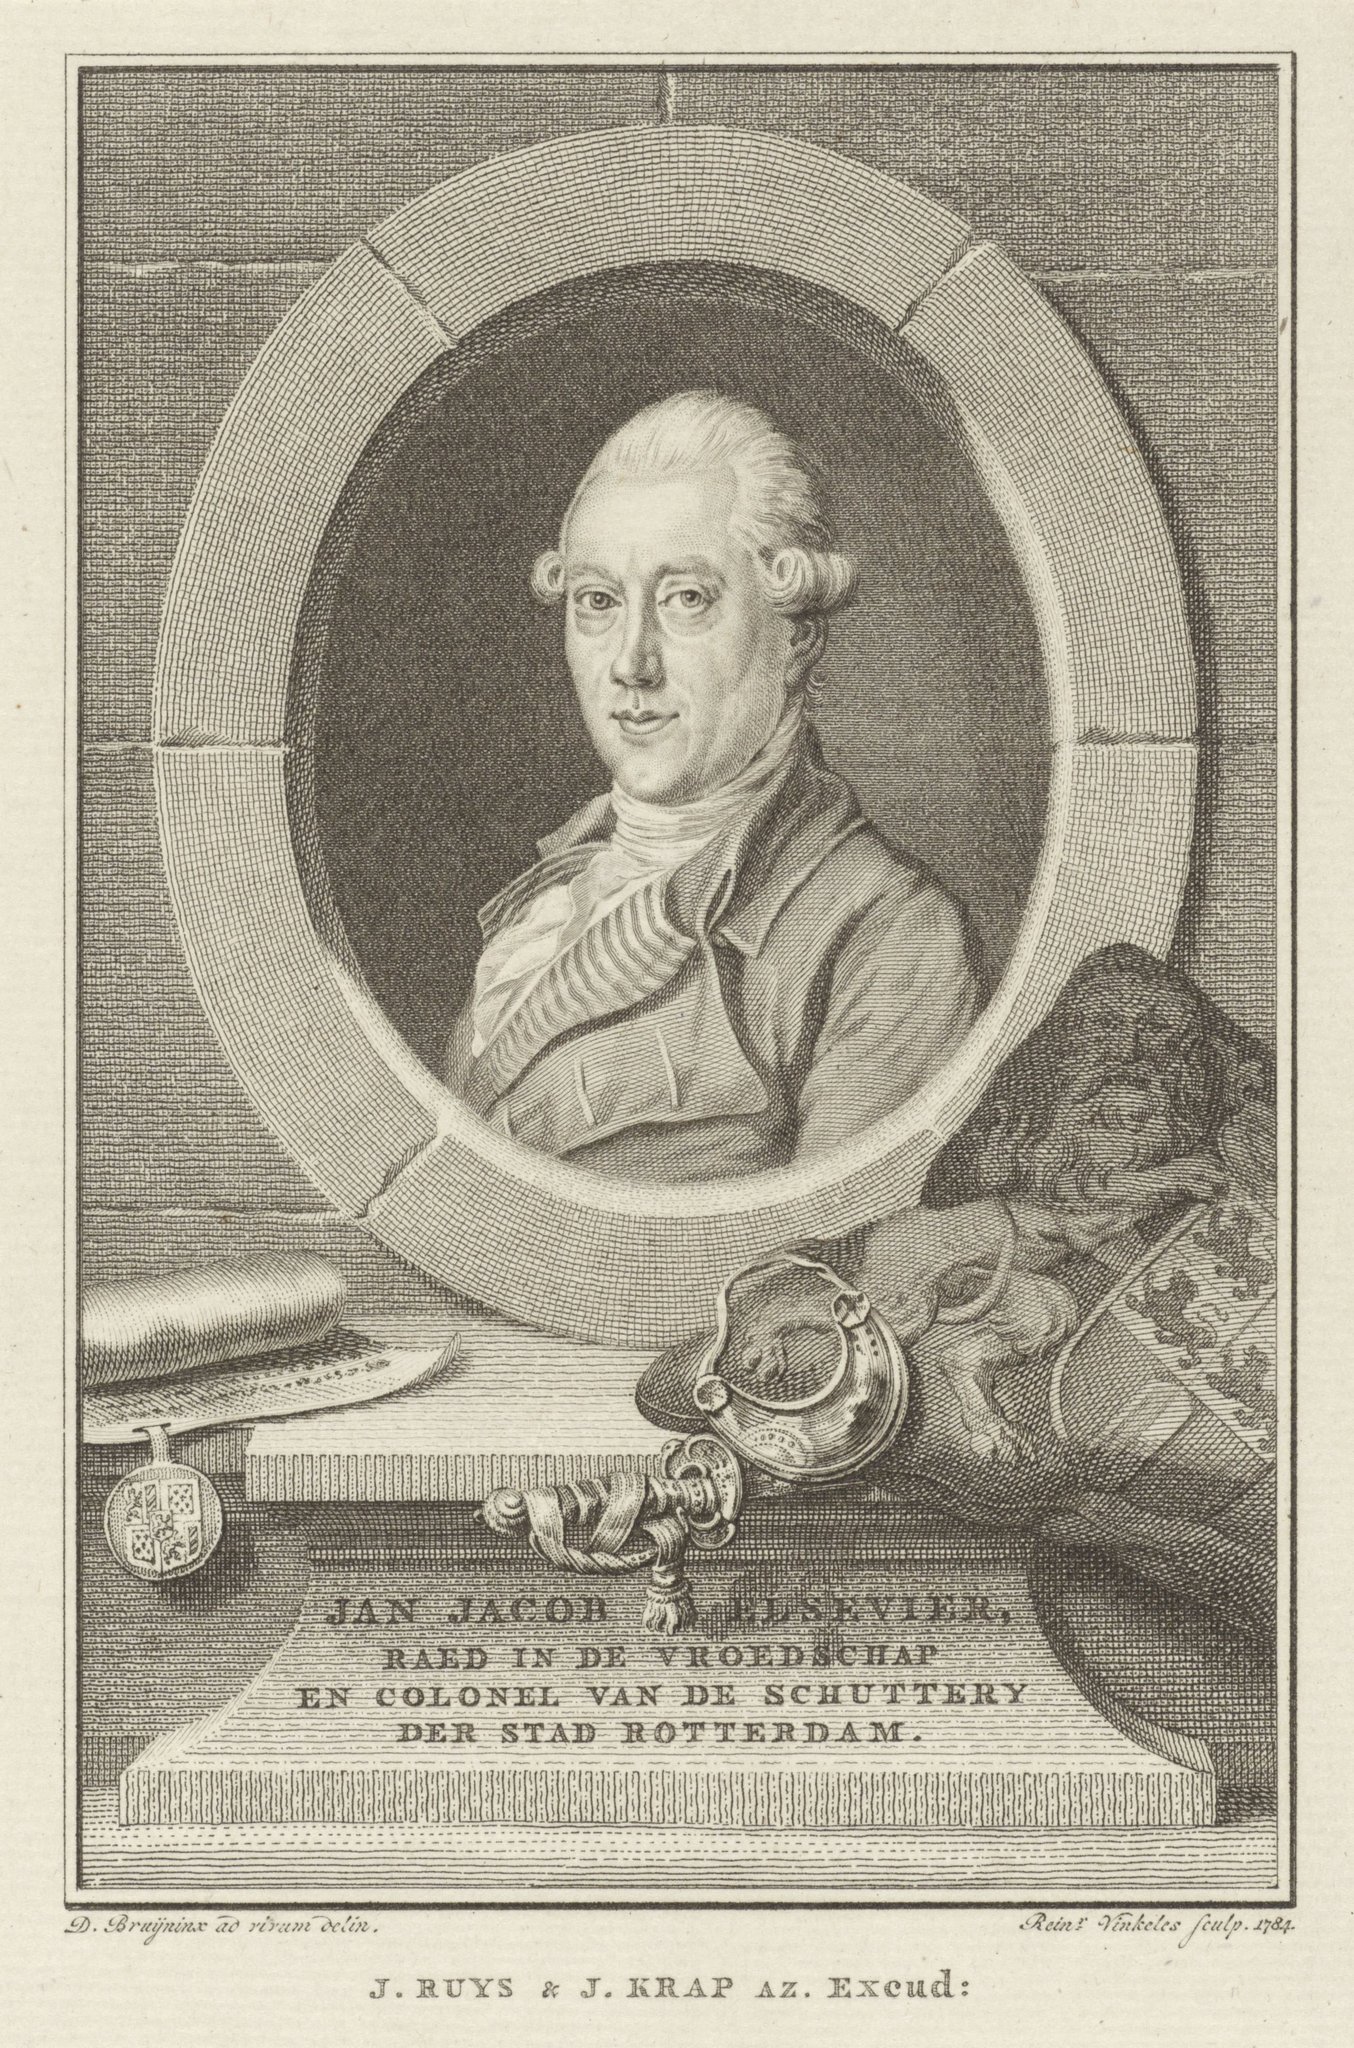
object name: print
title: Portret van Jan Jacob Elsevier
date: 1784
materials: paper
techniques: engraving, etching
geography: amsterdam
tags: rotterdam, delfshaven, mayor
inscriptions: collector's mark: Lugt 2233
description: Portret van Jan Jacob Elsevier, vroedschapslid en kolonel van de schutterij van de stad Rotterdam.